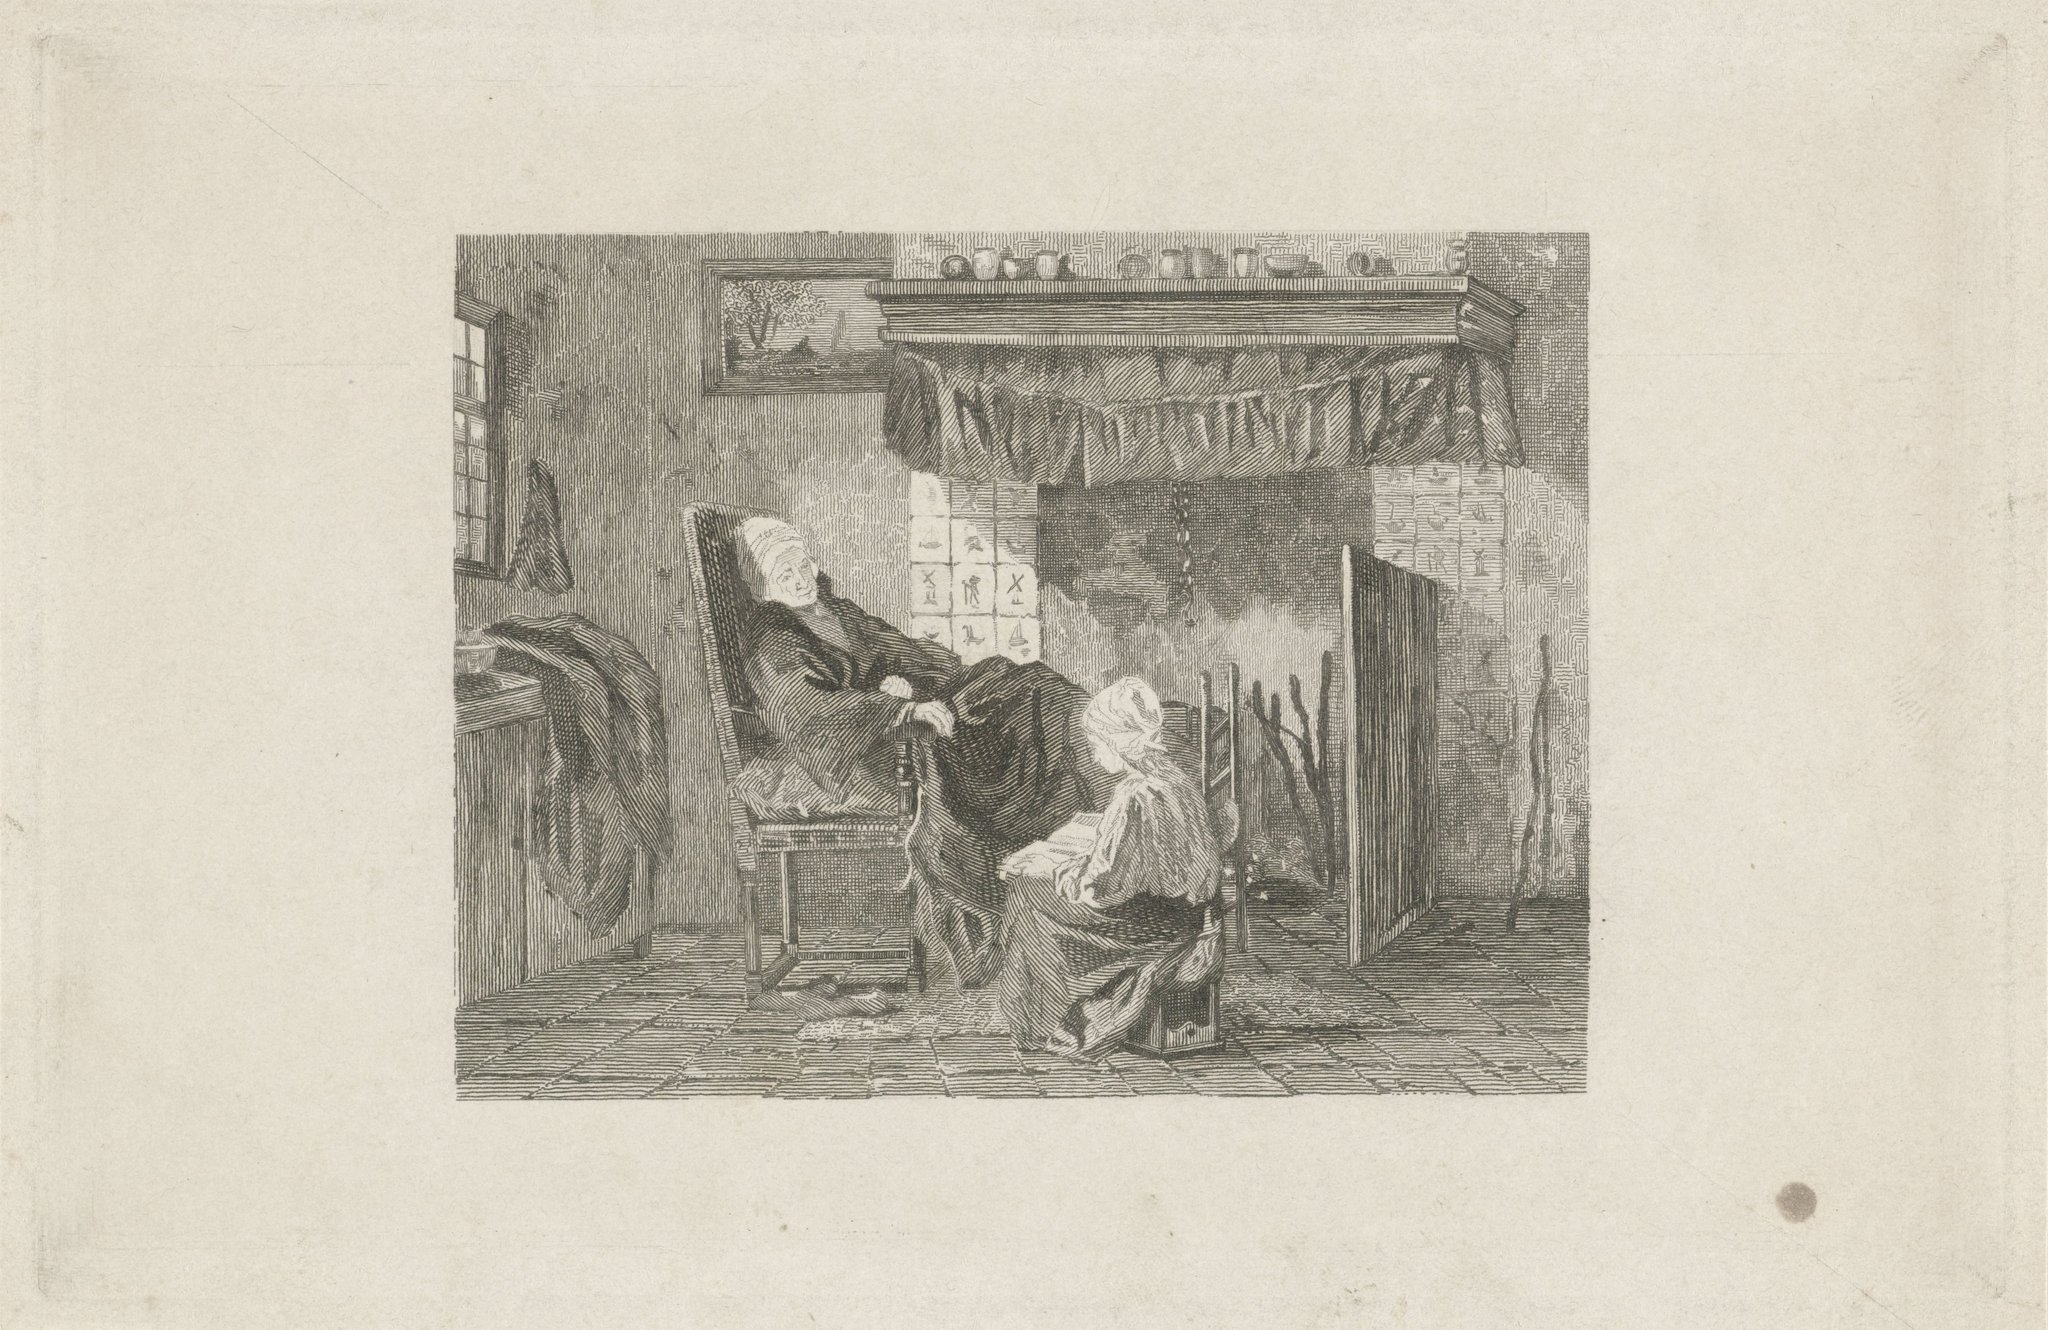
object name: print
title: Oude vrouw voor een haardvuur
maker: johann heinrich maria hubert rennefeld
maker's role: print maker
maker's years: 1832-1877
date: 1845-1877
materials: paper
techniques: etching, roulette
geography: amsterdam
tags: reading, foot-stove, open hearth, fire-place, old woman, chair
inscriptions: collector's mark: Lugt 2228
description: In een vertrek zit een oude zieke vrouw in een armstoel voor het haardvuur. Naast haar zit een kind op een stoof (voor) te lezen uit een boek.